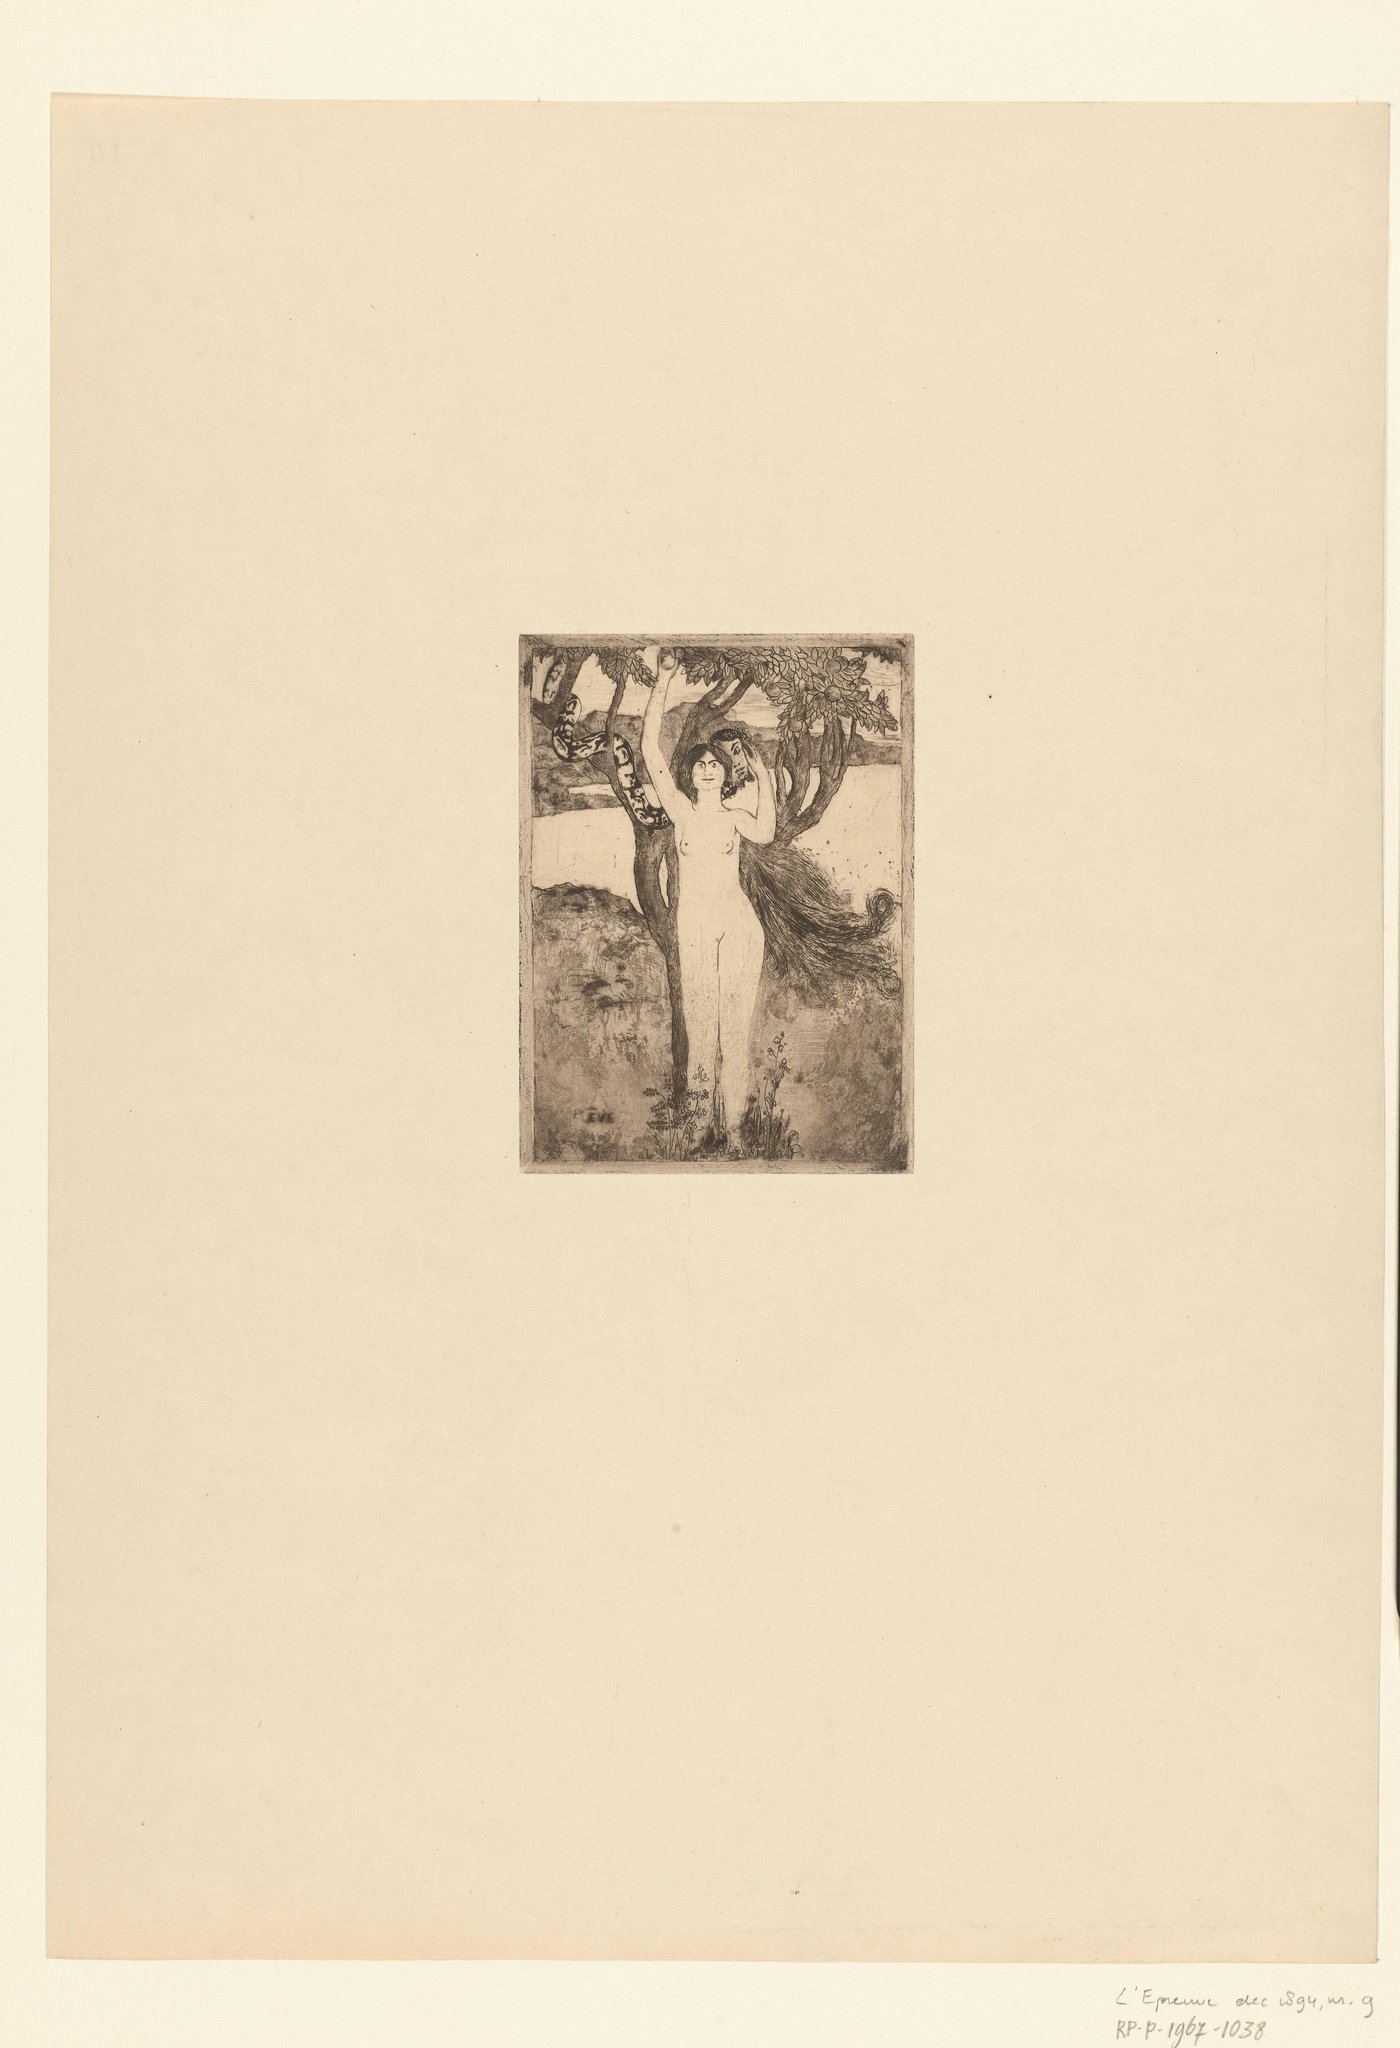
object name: print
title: L'Epreuve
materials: paper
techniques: aquatint, drypoint, etching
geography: paris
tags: eve takes the fruit, the serpent tries to persuade eve to take some of the fruit (usually an apple)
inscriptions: collector's mark: Lugt 2760, collector's mark: Lugt 2228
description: Eva staat voor de boom van kennis van goed en kwaad en plukt een appel van een tak boven haar. De slang met een kop kronkelt zich achter haar rug langs de takken van de boom.